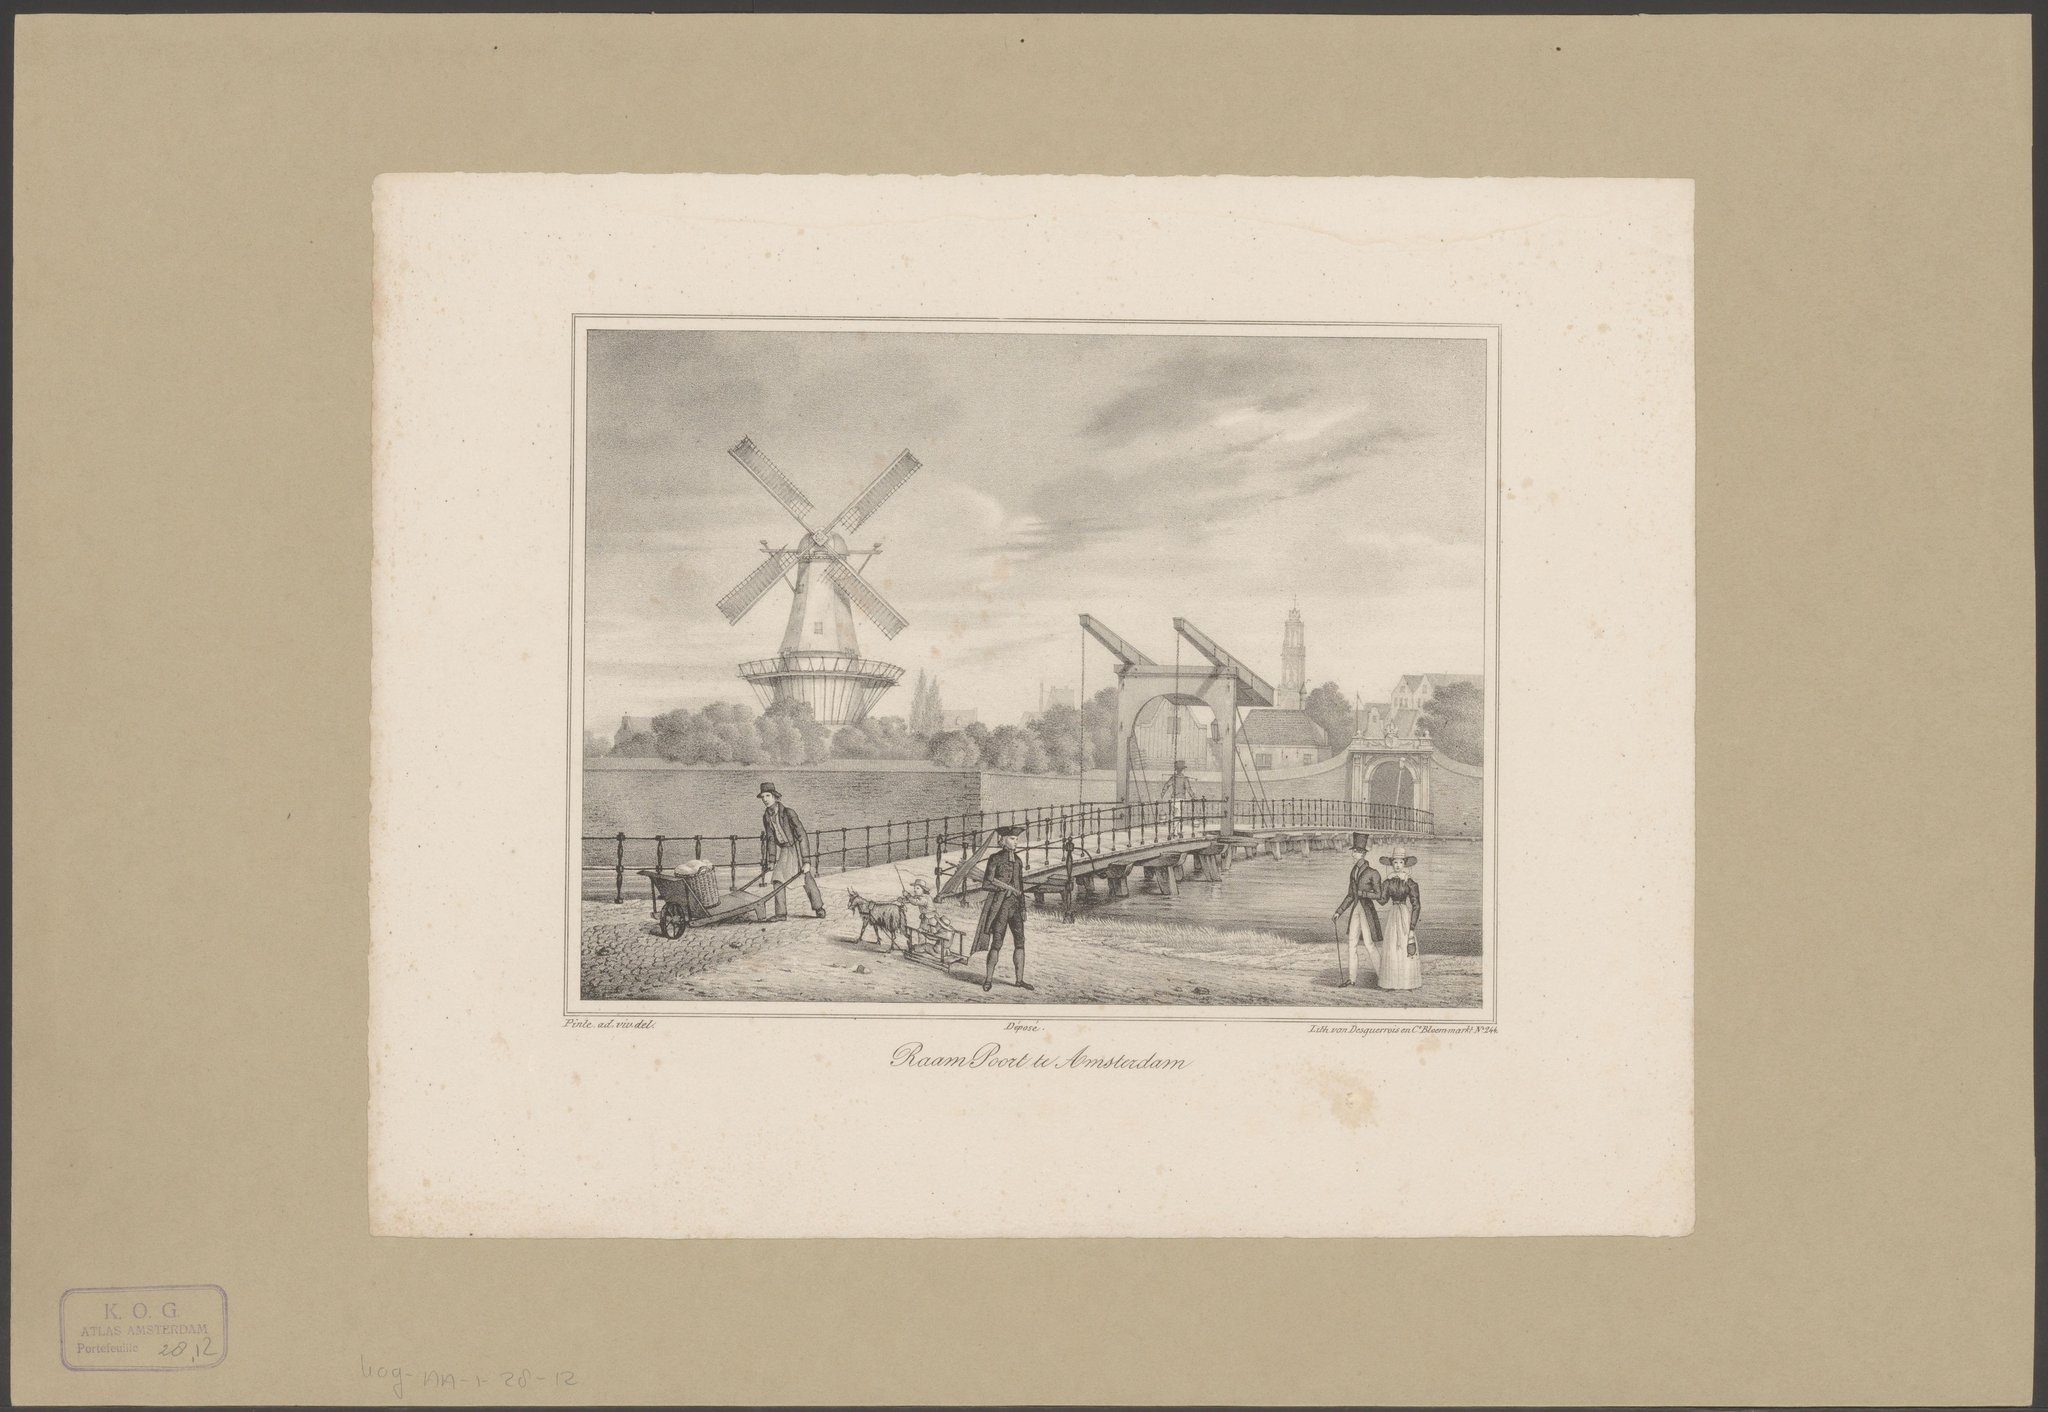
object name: print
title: Gezichten van de Zes Voornaamste Poorten der Stad Amsterdam. 1ste Cahier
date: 1828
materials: paper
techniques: lithograph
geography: amsterdam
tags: city-gate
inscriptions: : ‘Déposé’, collector's mark: Lugt 1641b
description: Onderdeel van een omslag met een serie van zes lithografieën van Amsterdamse poorten. Onderwerpsrubriek binnen de Atlas Amsterdam: Poorten, verzamelbladen, A. Raampoort.